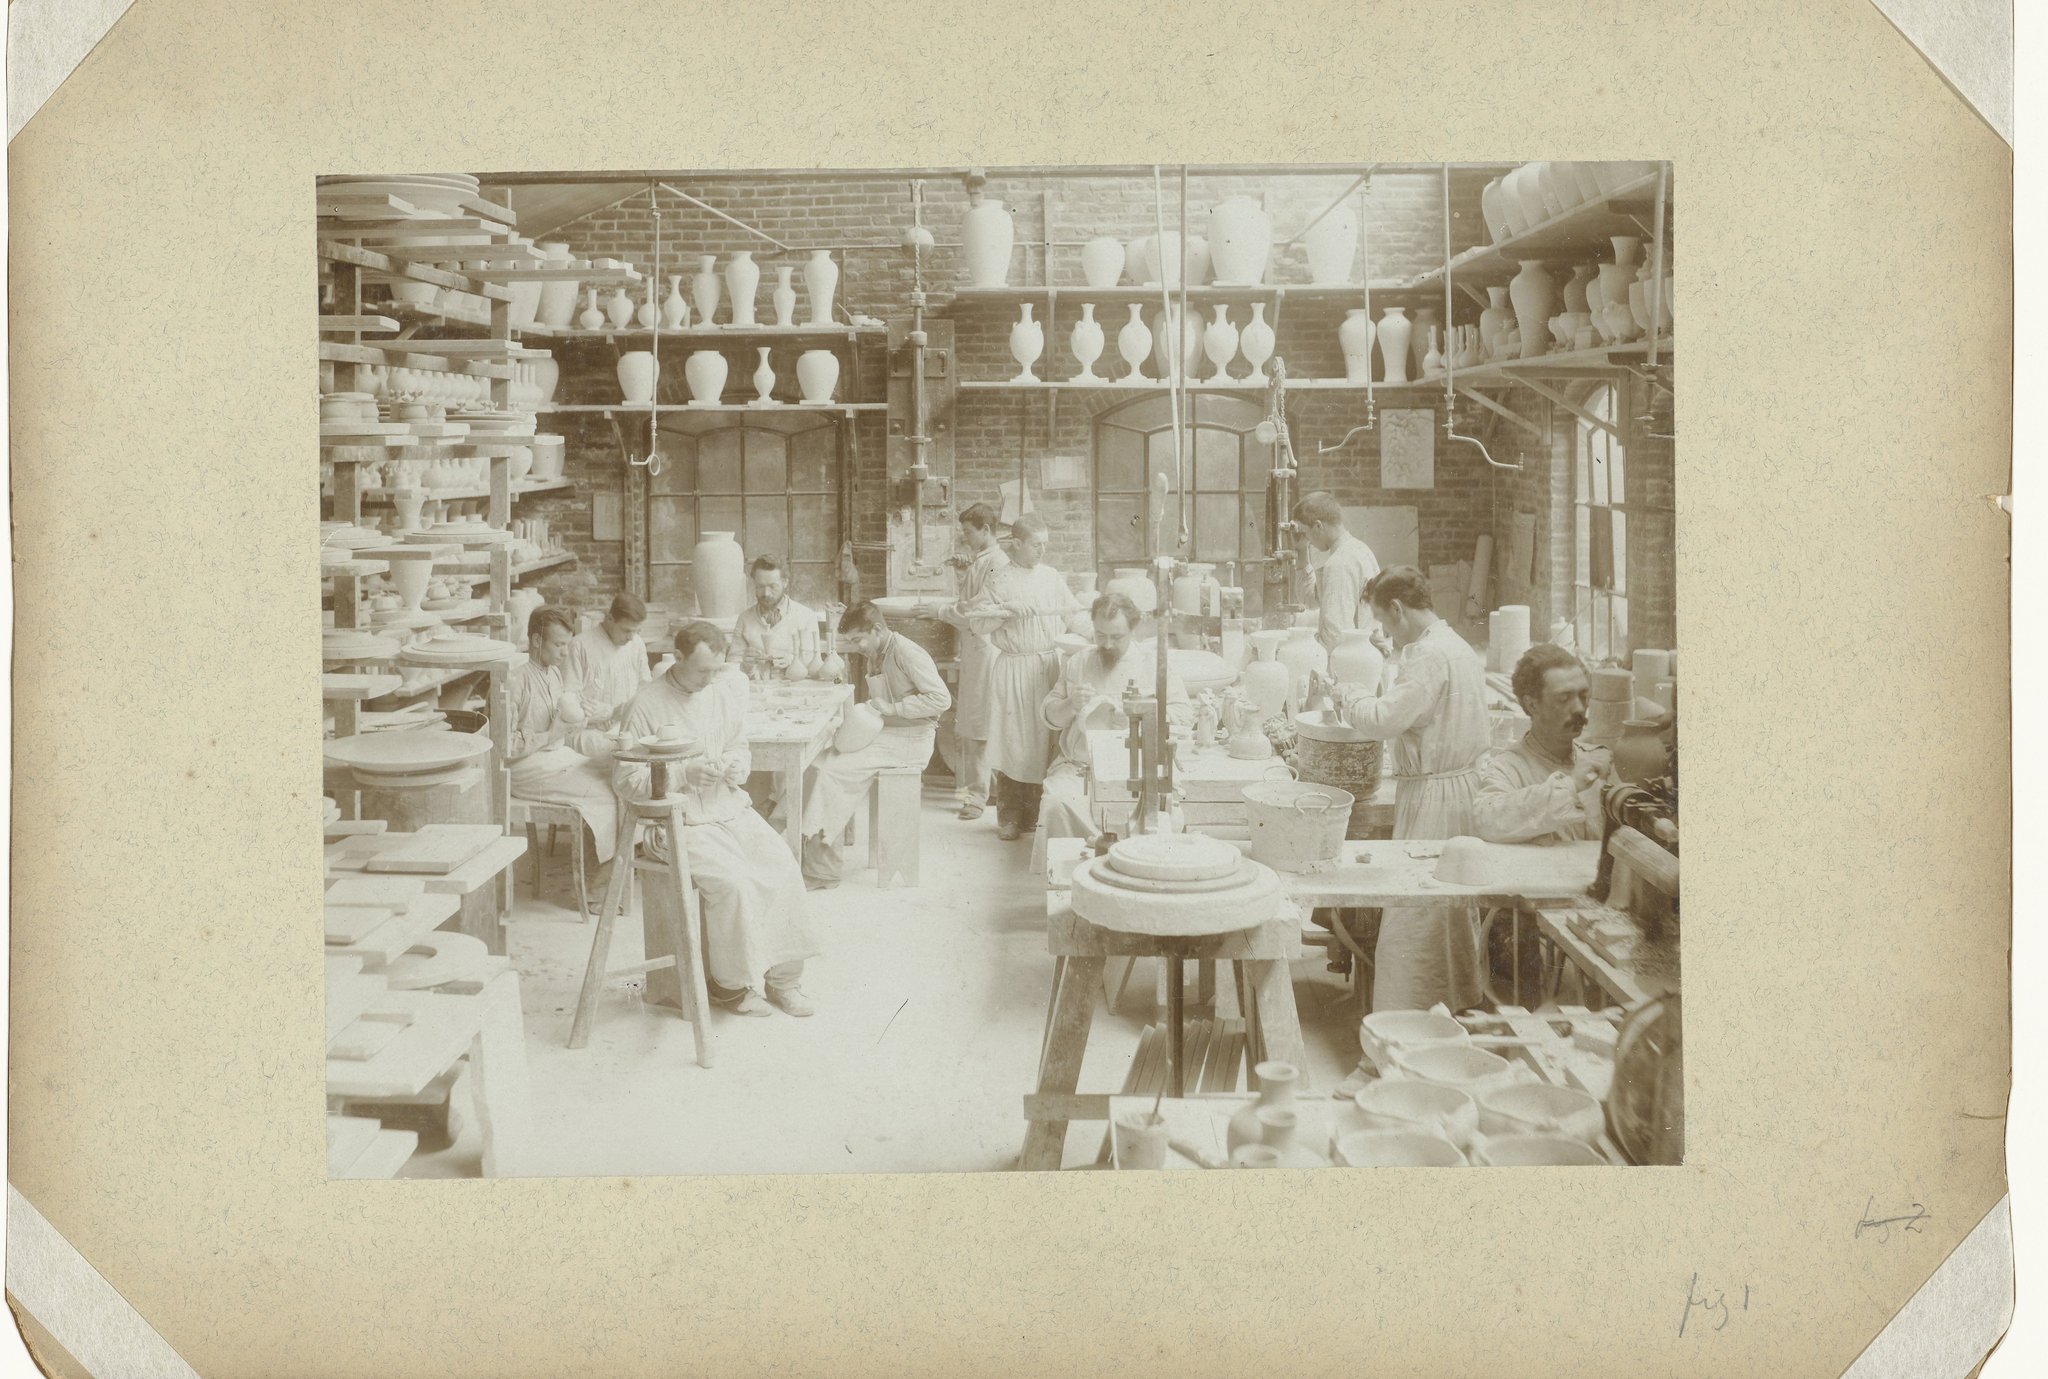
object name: photograph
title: Mannen werken in de modelmakerij van porseleinfabriek Rozenburg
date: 1890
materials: cardboard, paper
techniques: collodion silver print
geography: the hague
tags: workshop-interior, the hague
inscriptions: stamp: ‘Ritsche & Landman Photografen Den Haag’